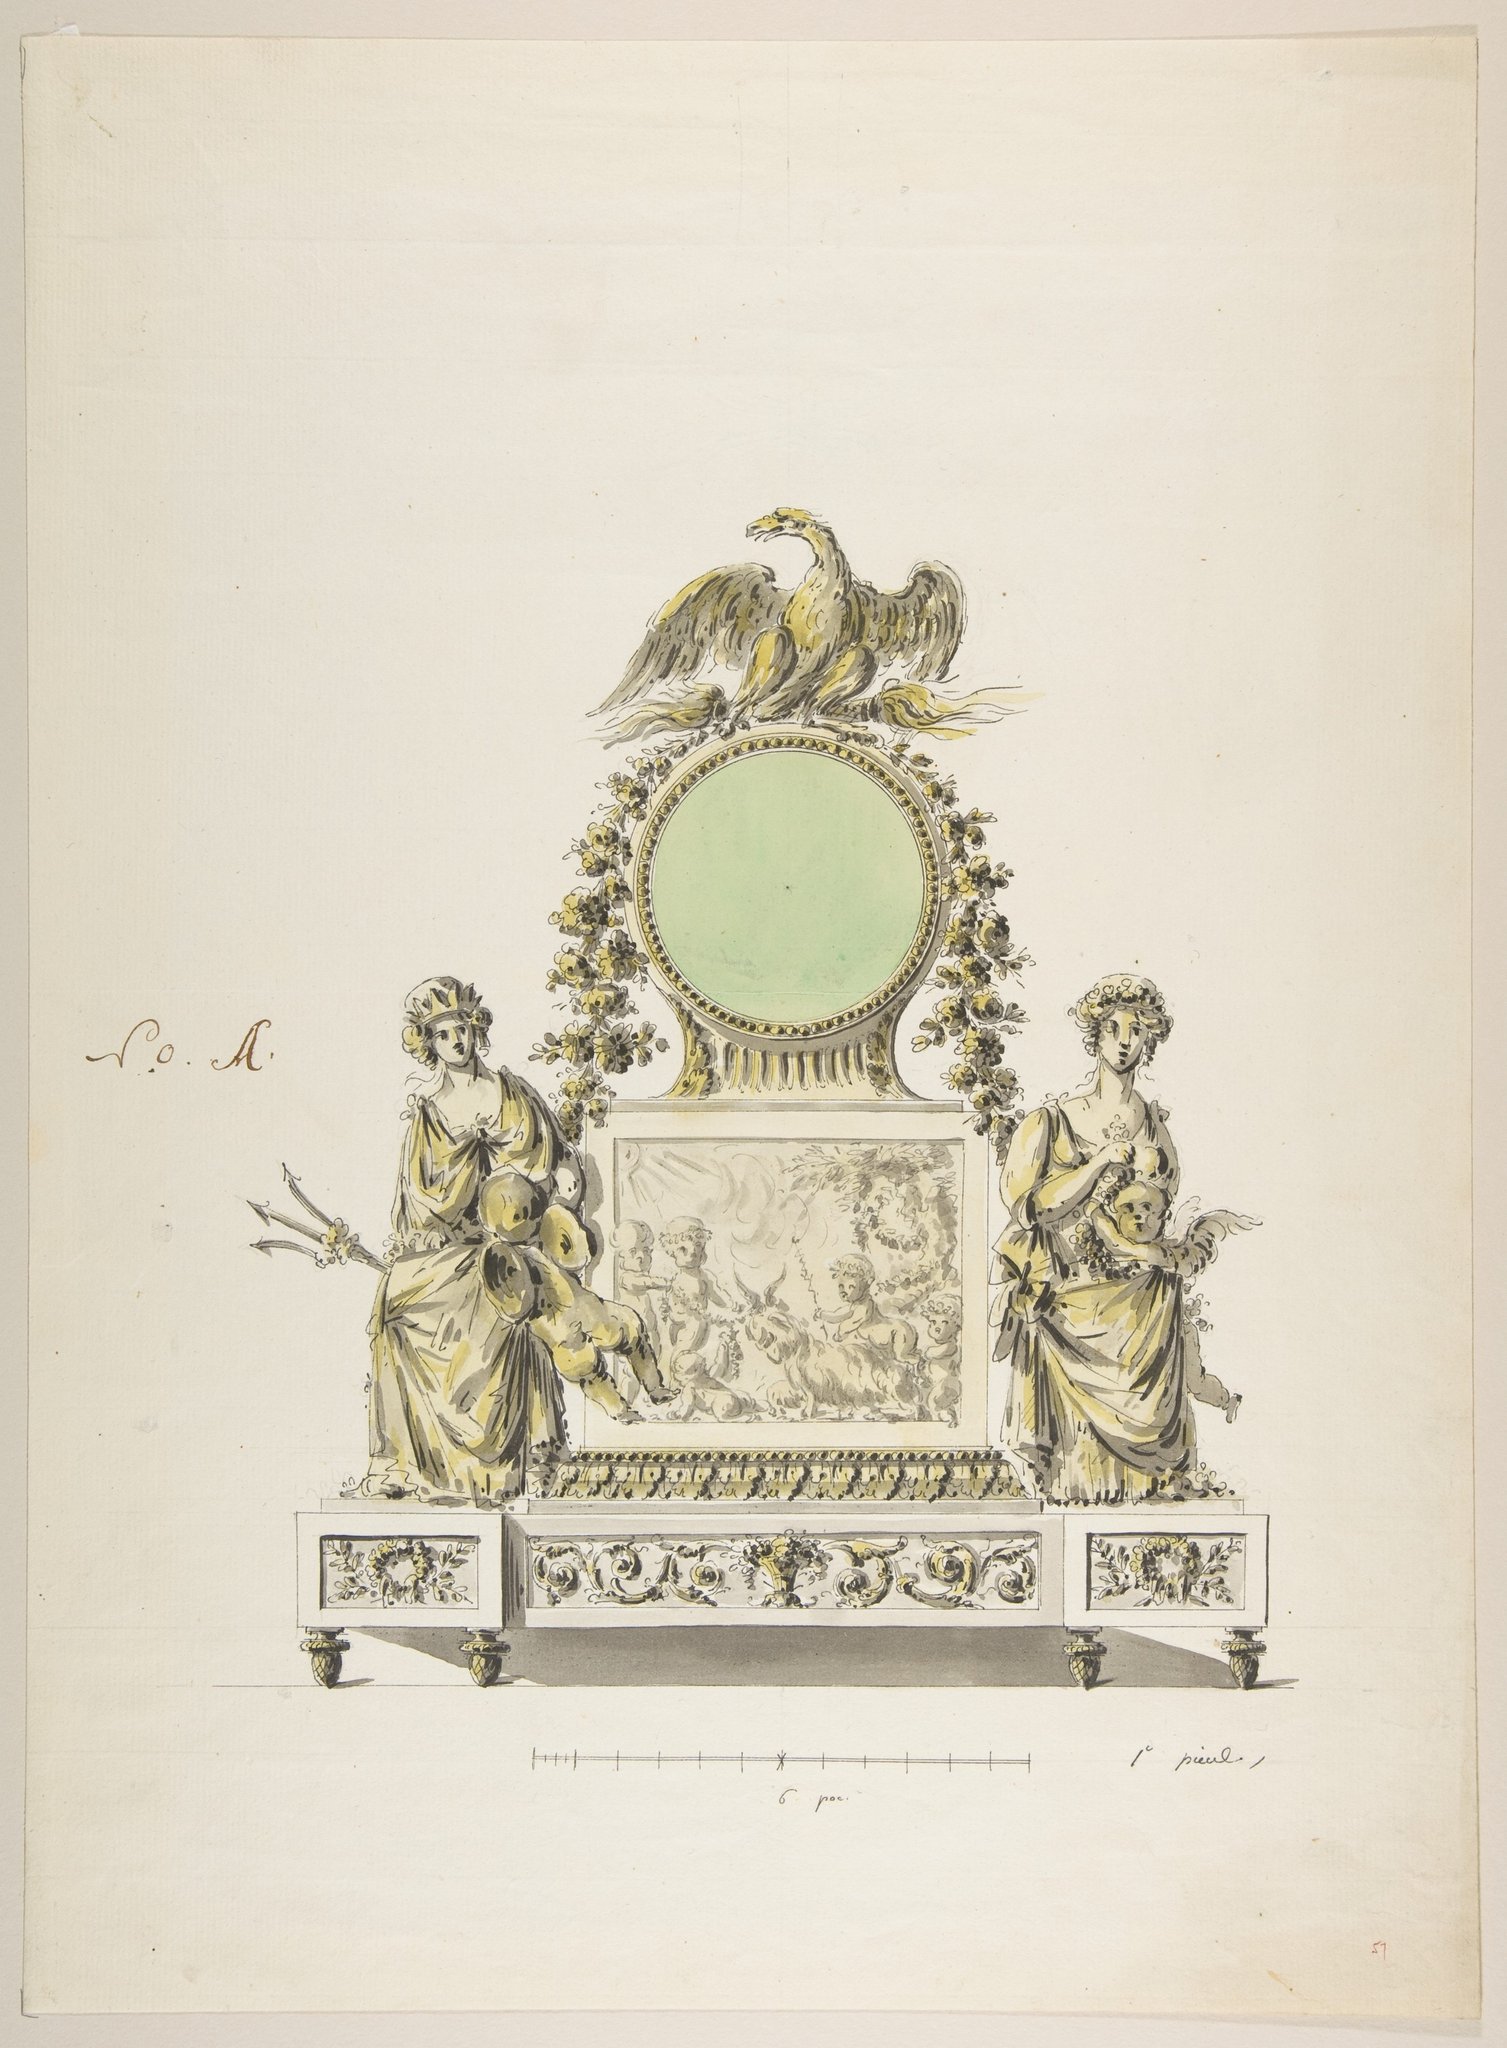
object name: drawing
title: Design for a Clock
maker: anonymous, french, 18th century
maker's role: artist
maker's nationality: french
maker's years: 1700-1800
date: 1770-1790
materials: ink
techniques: brush, pen, wash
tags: eagles,garlands,women,clocks